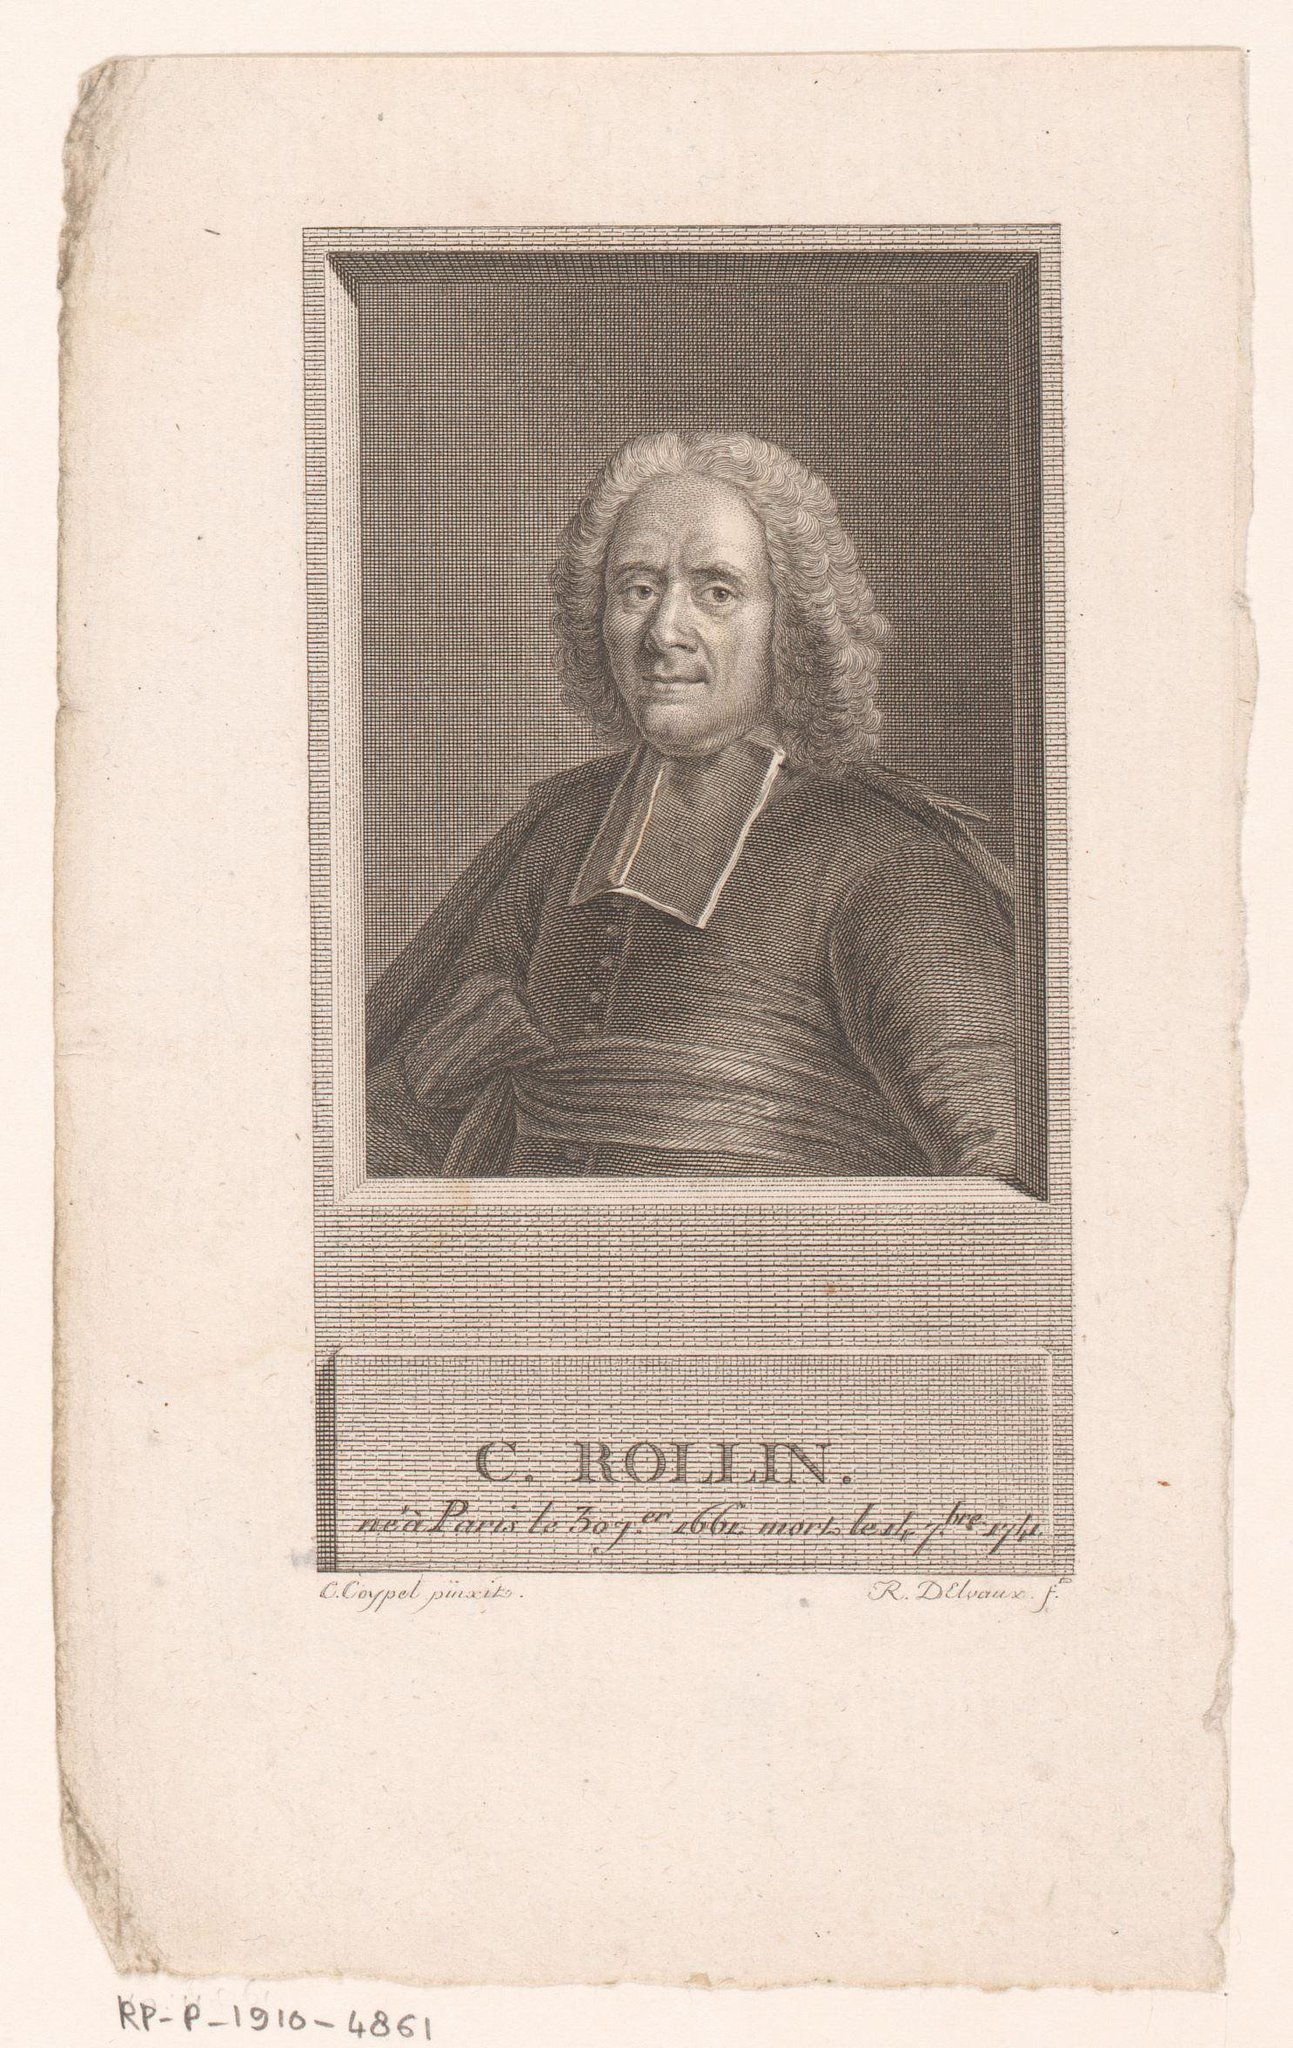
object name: print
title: Portret van Charles Rollin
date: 1760-1823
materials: paper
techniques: engraving, etching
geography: france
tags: paris, charles rollin, historical persons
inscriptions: collector's mark: Lugt 2228